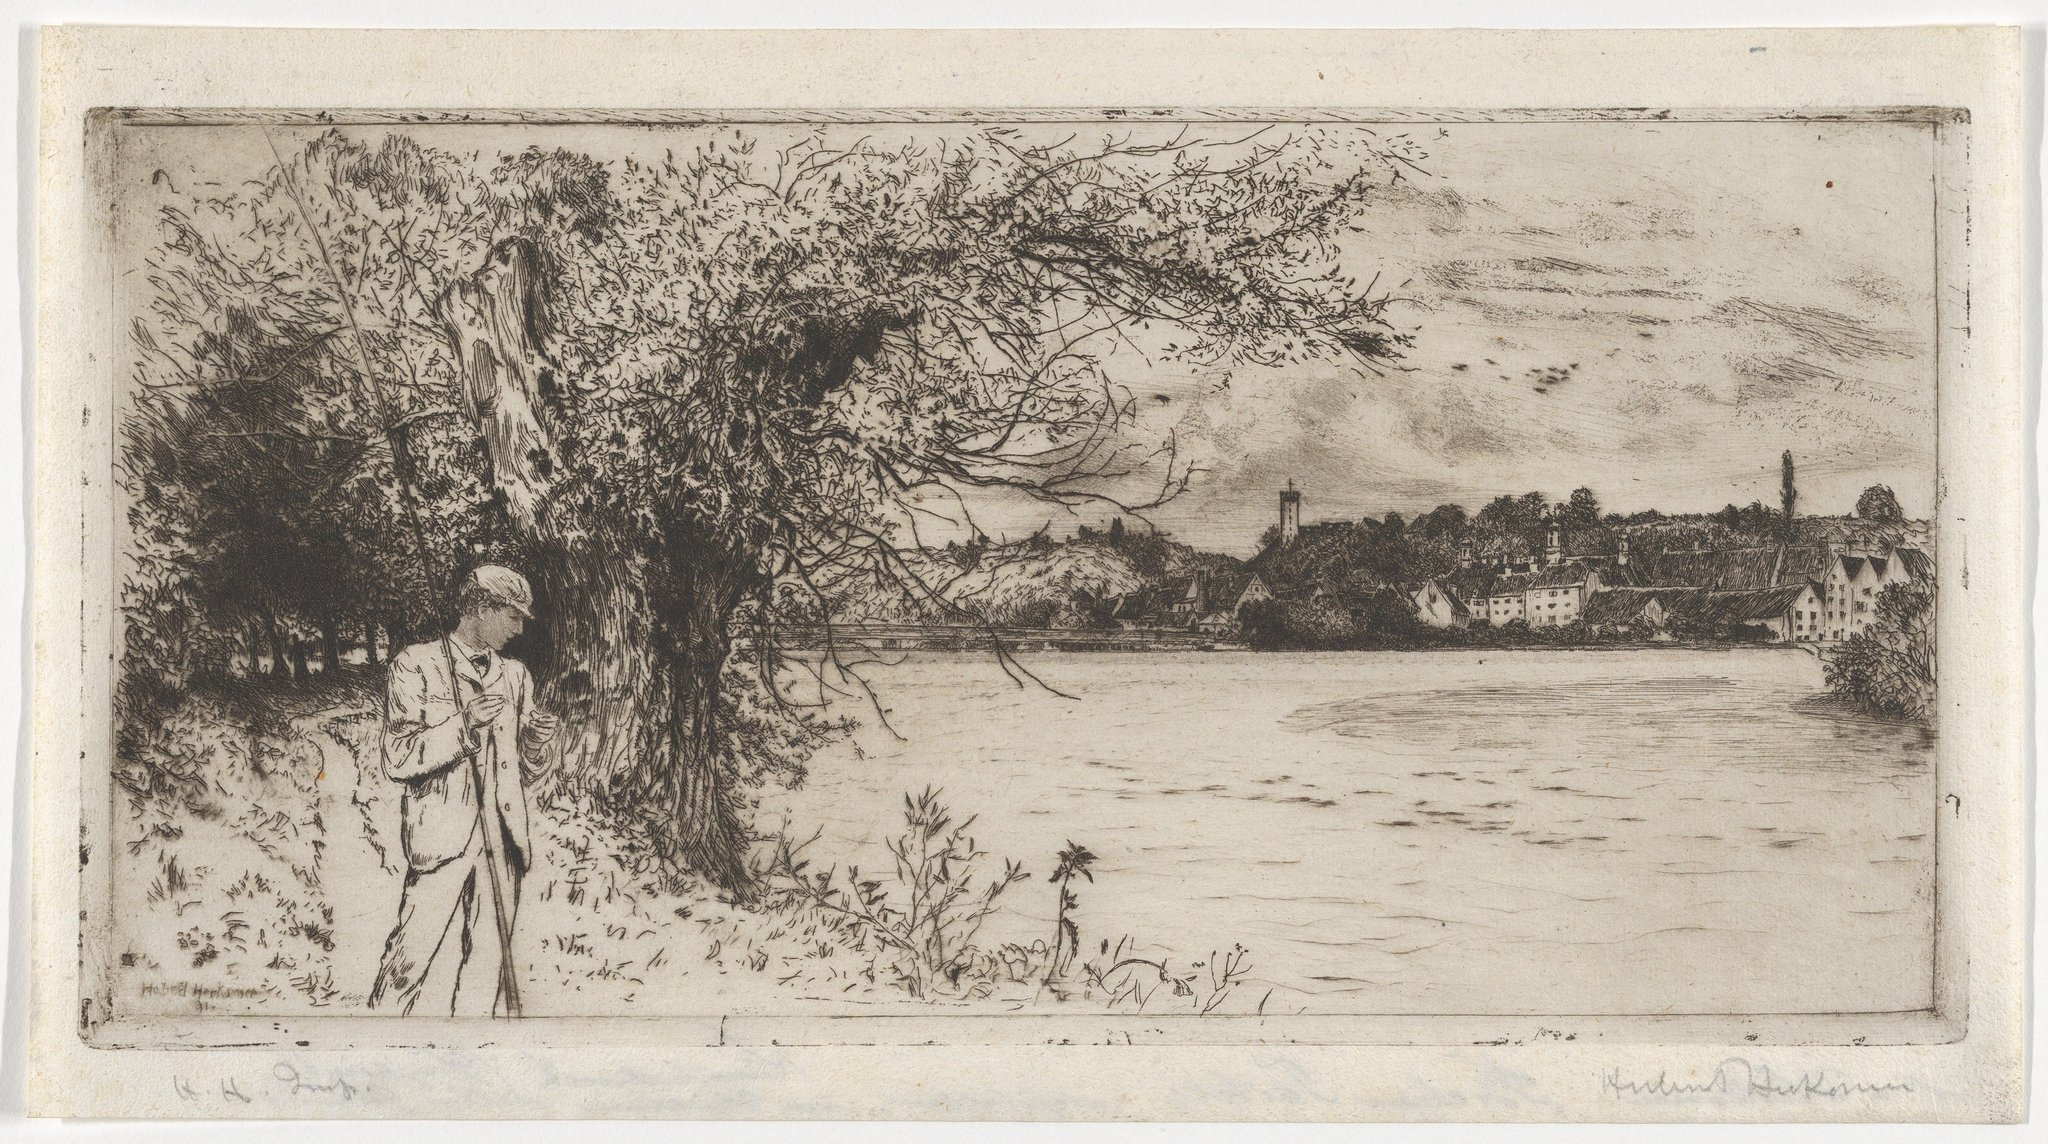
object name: print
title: Broken Tackle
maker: sir hubert von herkomer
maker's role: artist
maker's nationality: british, born germany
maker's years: 1849-1914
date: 1891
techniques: drypoint, etching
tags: men,rivers,trees